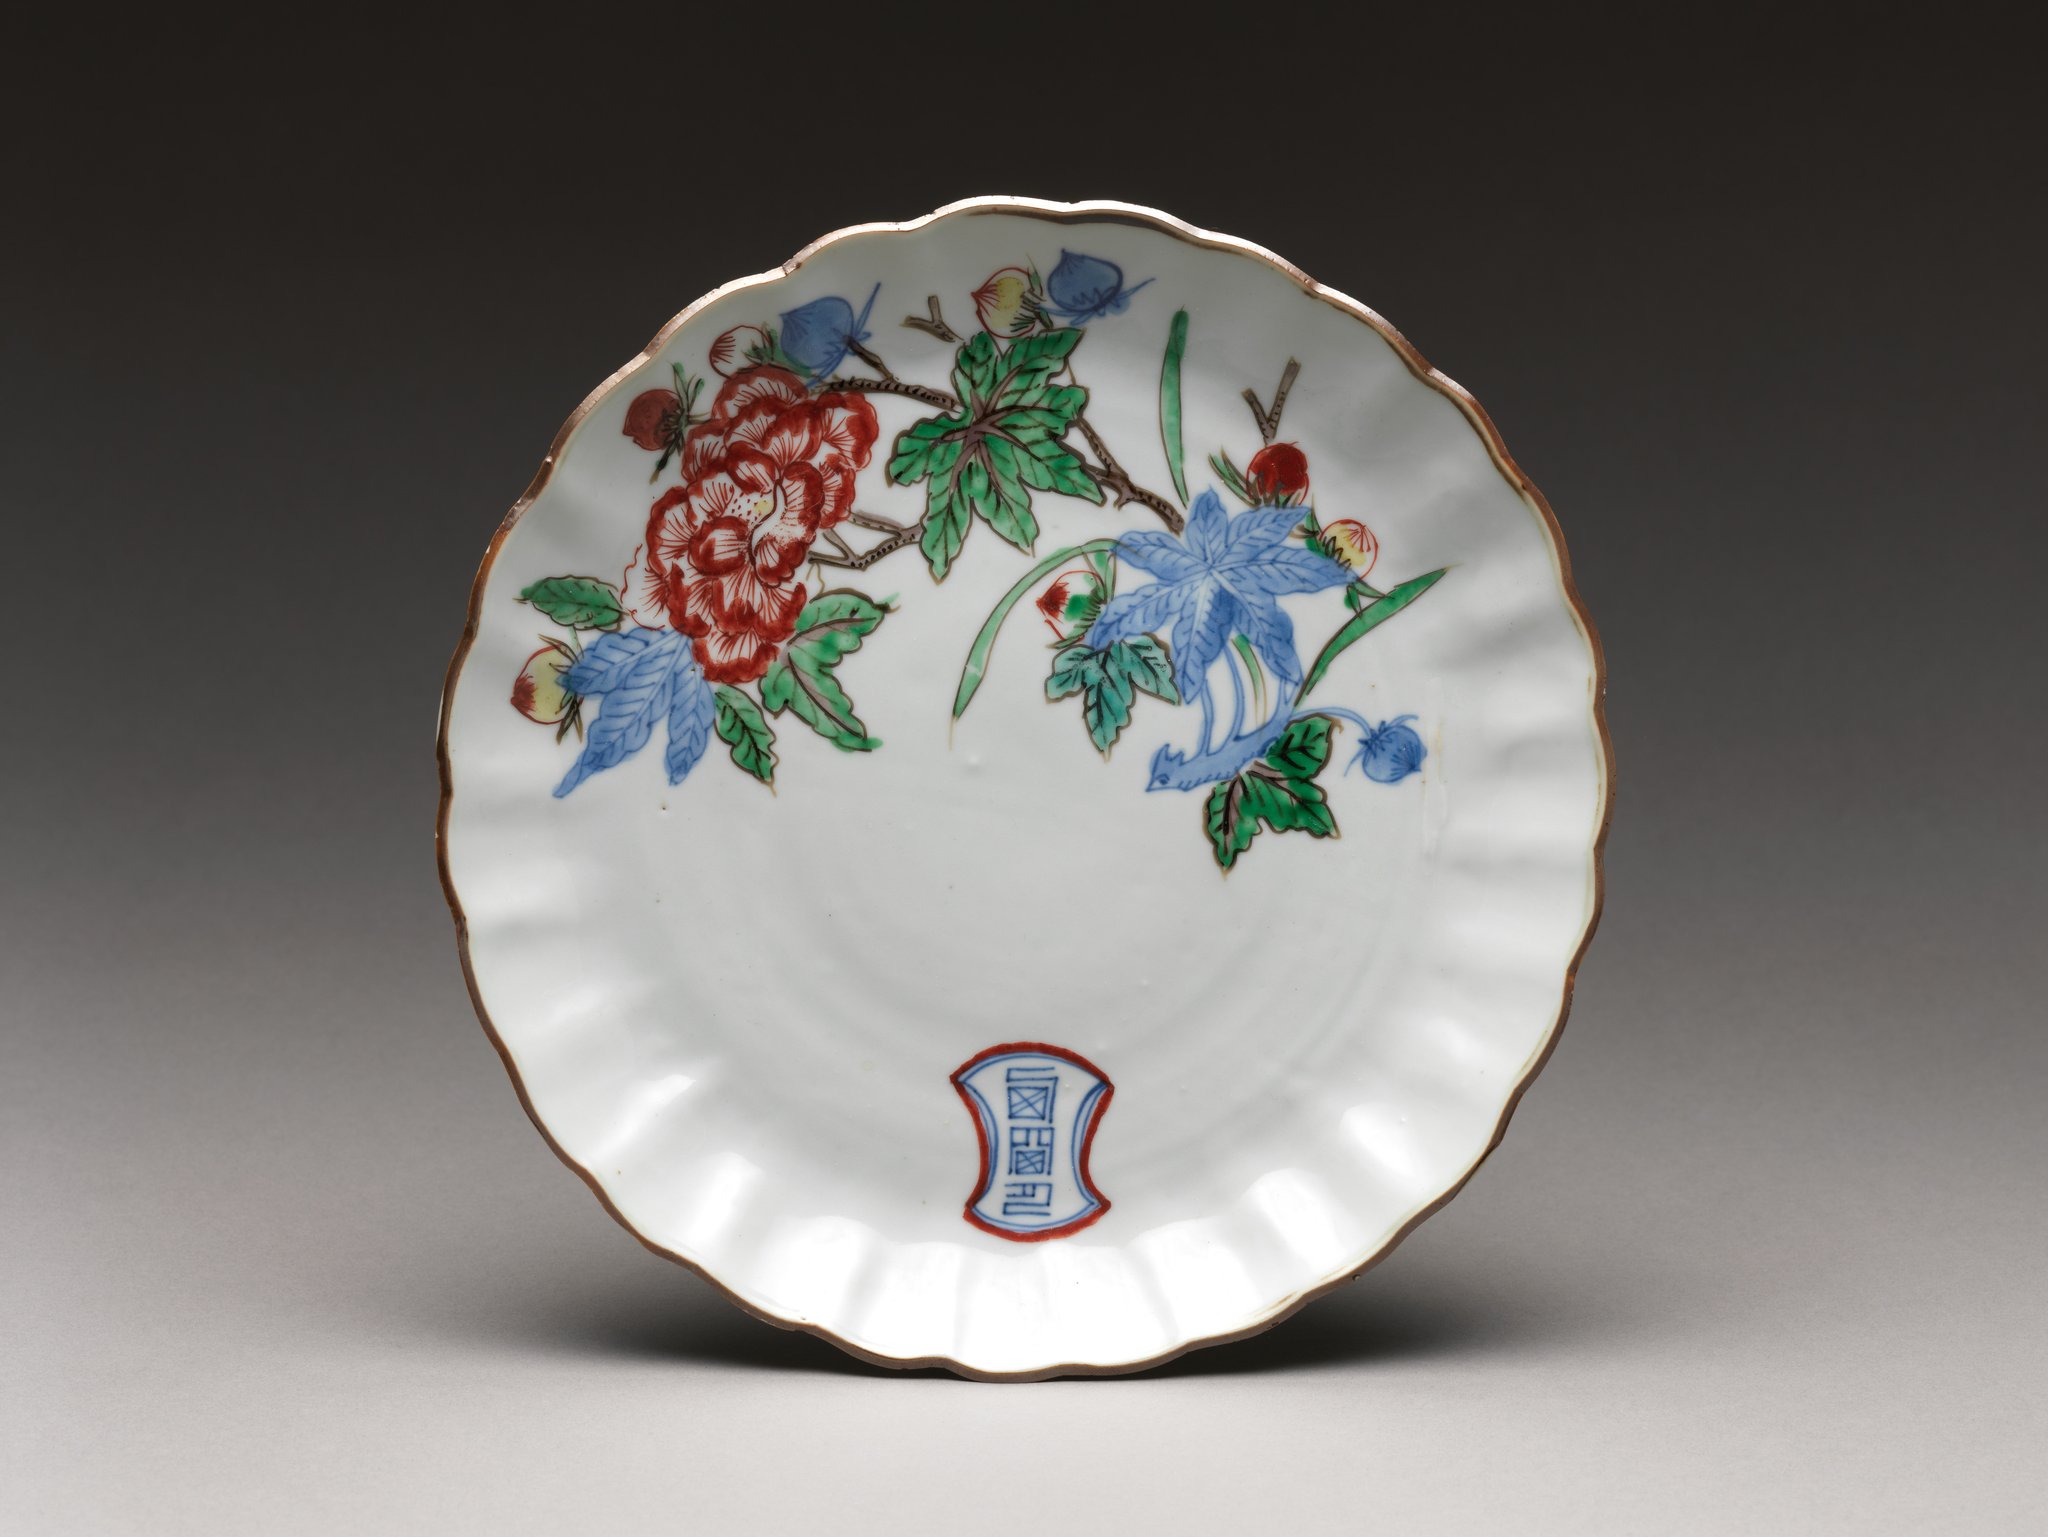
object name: dish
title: Dish with Peonies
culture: chinese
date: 1634-1666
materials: cobalt, enamel, glaze, porcelain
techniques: painting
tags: peonies,leaves